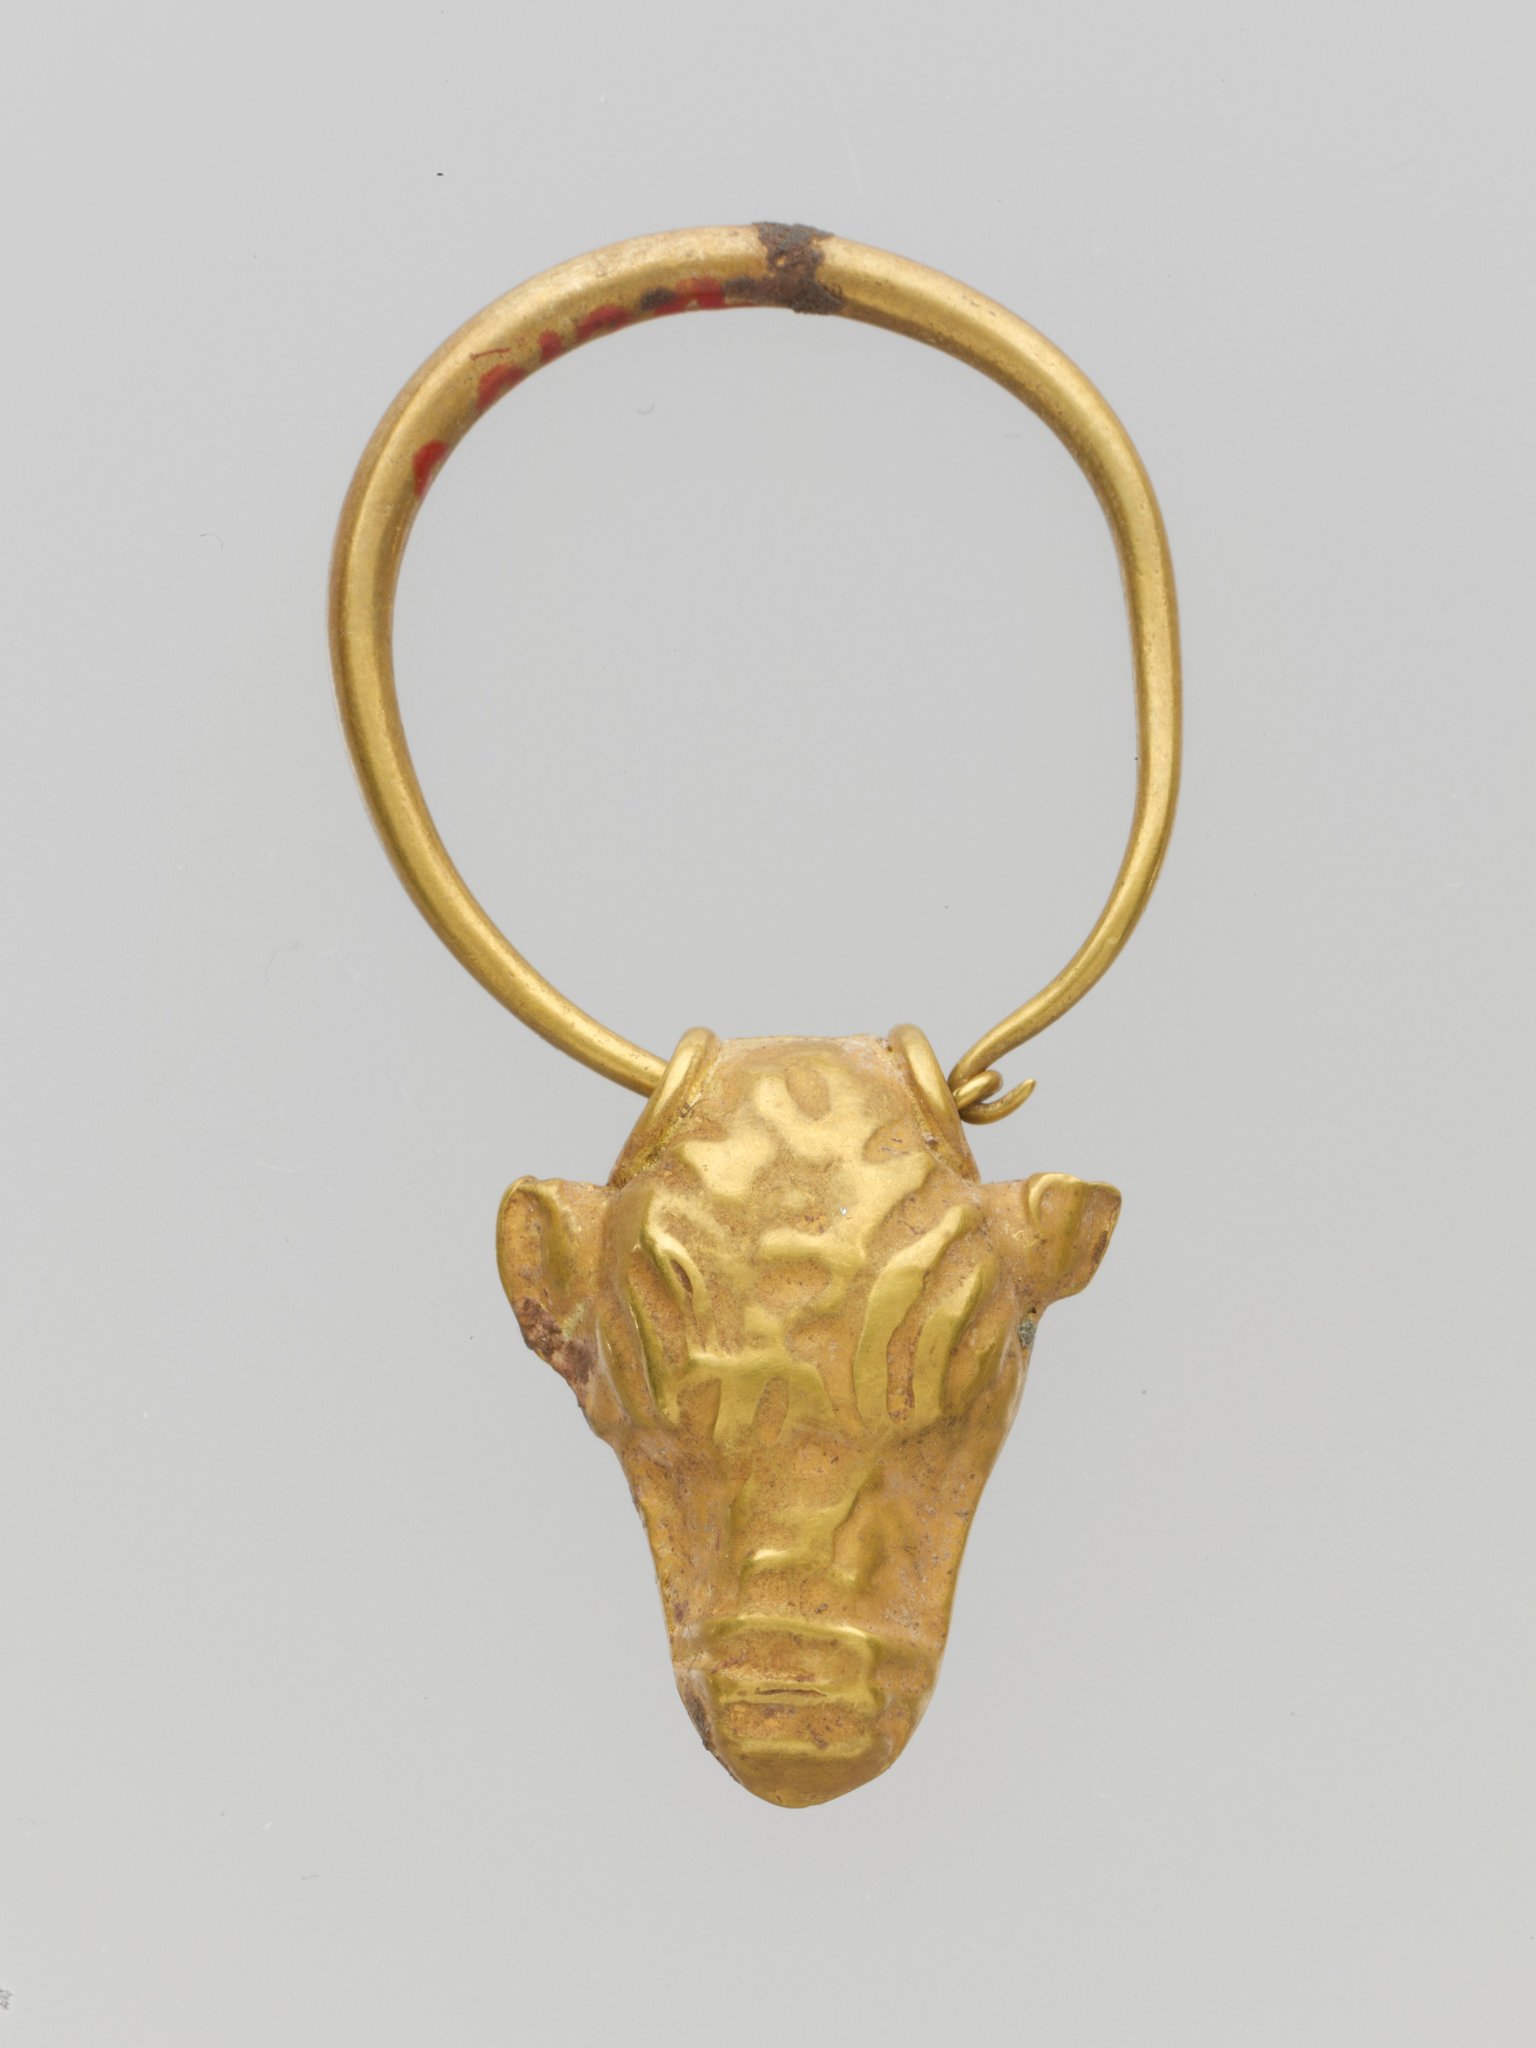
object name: earring with head of bull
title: Gold pendant in the form of a bull's head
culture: cypriot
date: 1400-1050 BCE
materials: gold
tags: bulls